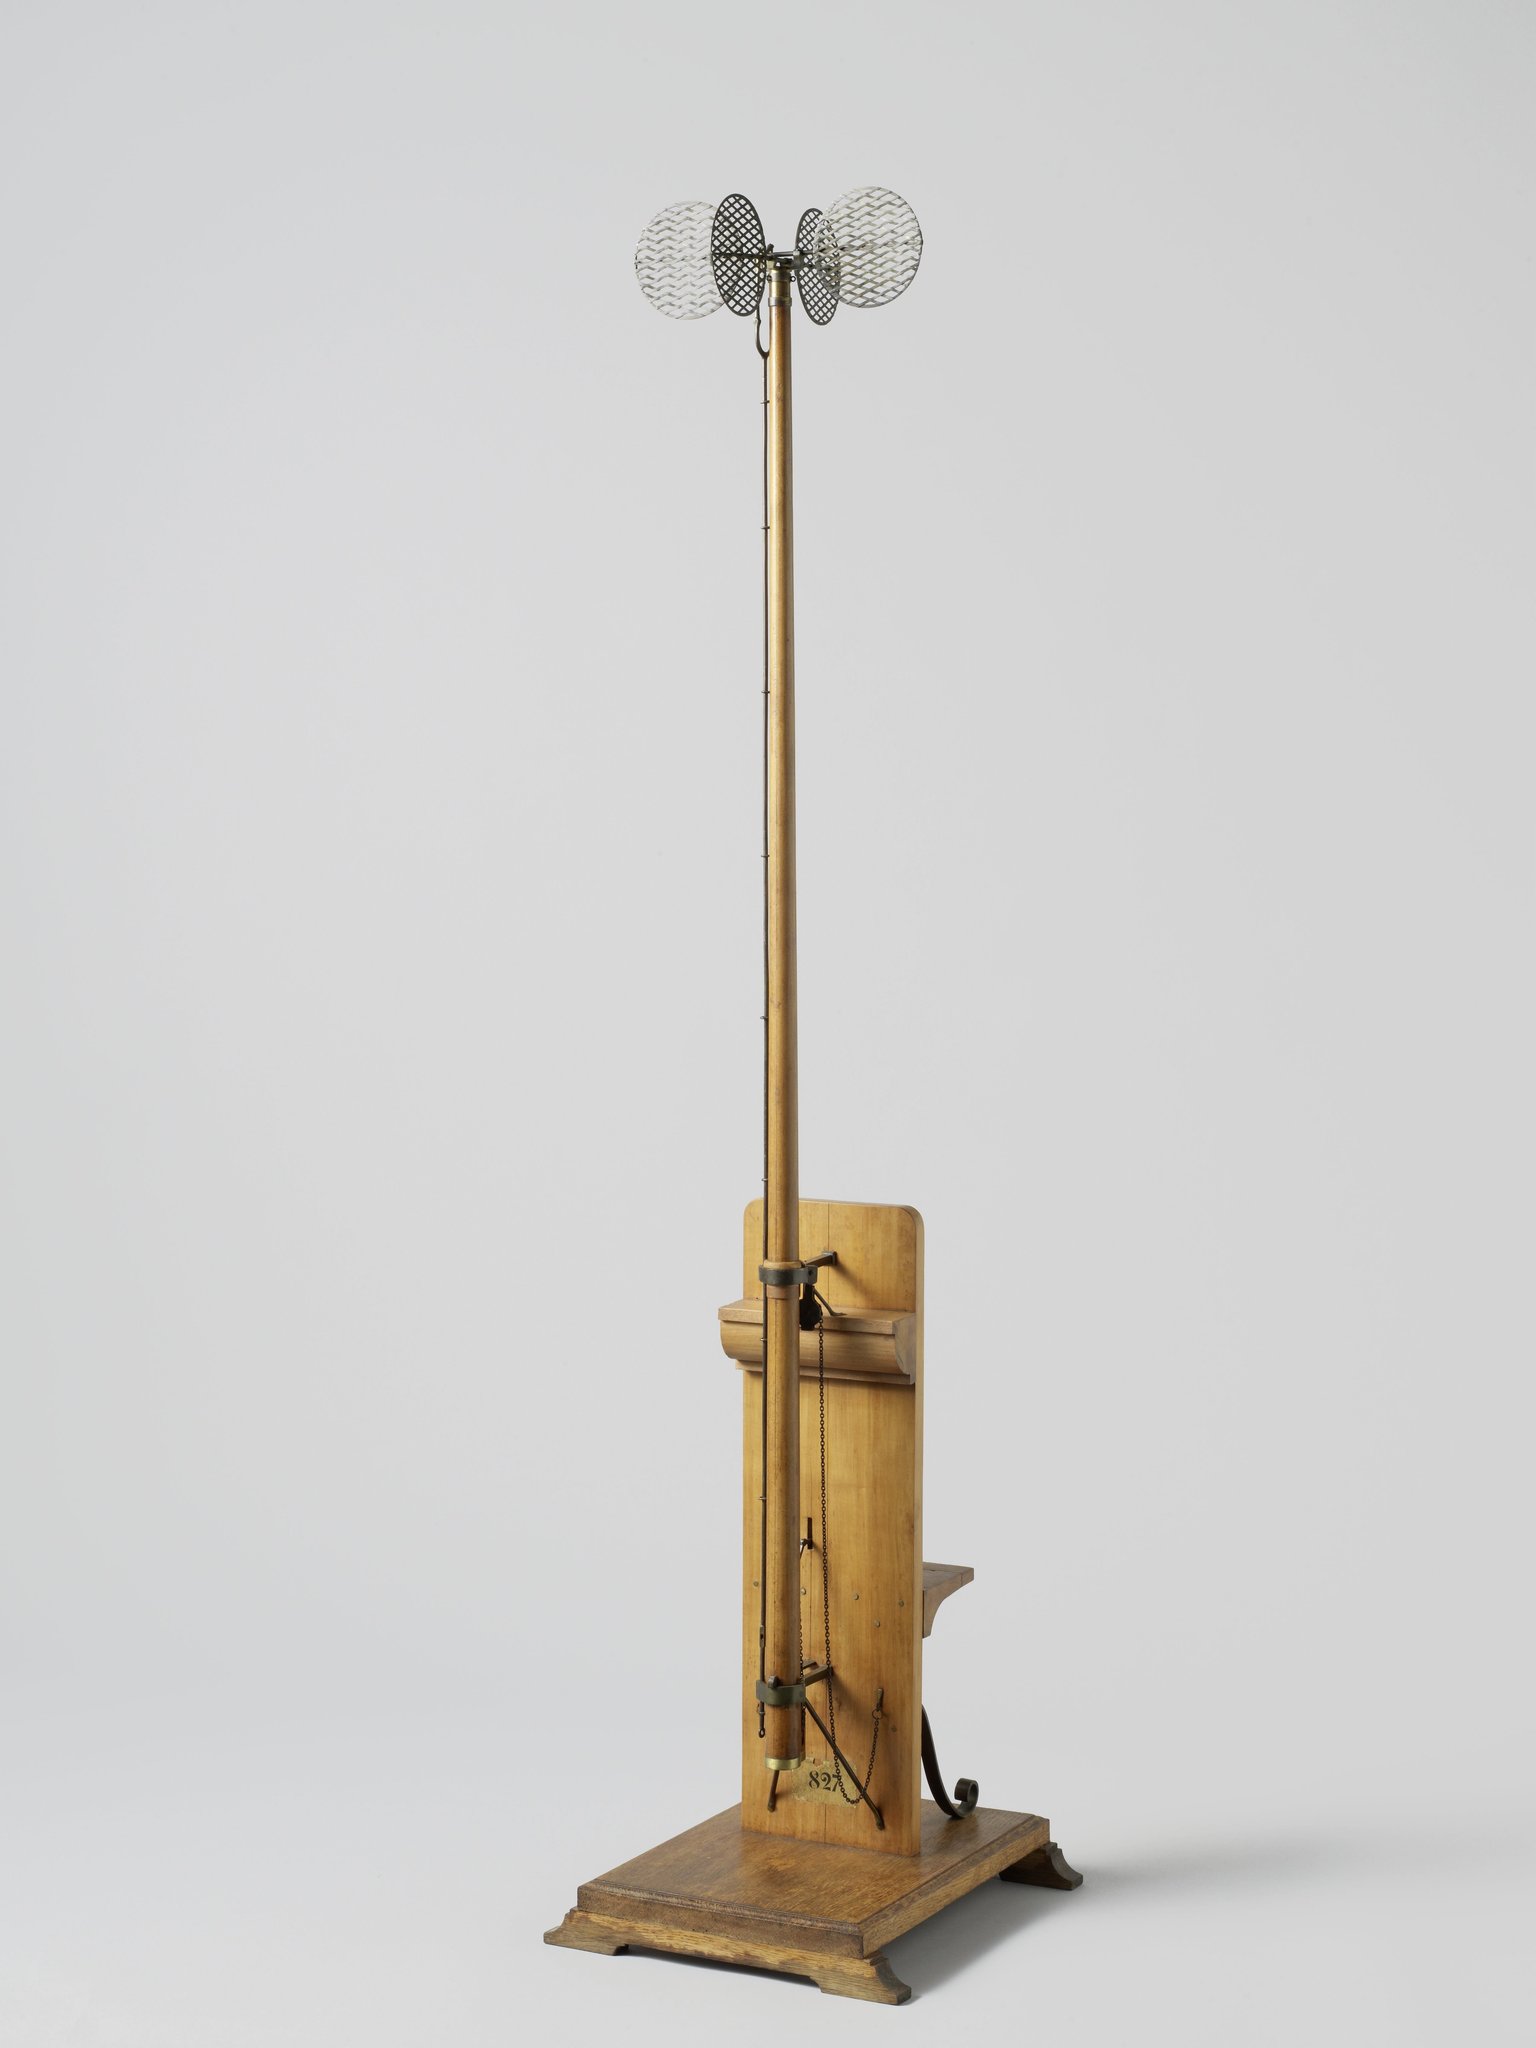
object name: demonstration model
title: Model of a Time Signal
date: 1854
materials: brass, wood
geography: flushing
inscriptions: label, on the base: ‘827’ former inventory label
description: Model van een seinpaal op een houten grondplank. Het model bestaat uit een paal met vier kruislings geplaatste ronde metalen roosters aan de top, bevestigd tegen een verticale plank. De roosters kunnen bediend worden met een mechanisme halverwege de verticale plank: door een hefboom met gewicht, opgesloten als de roosters in verticale positie staan, los te laten schieten de roosters in horizontale stand. De paal kan bovendien geschoten worden met een ketting die over schijven loopt, maar niet voordat het seinmechanisme is verwijderd.